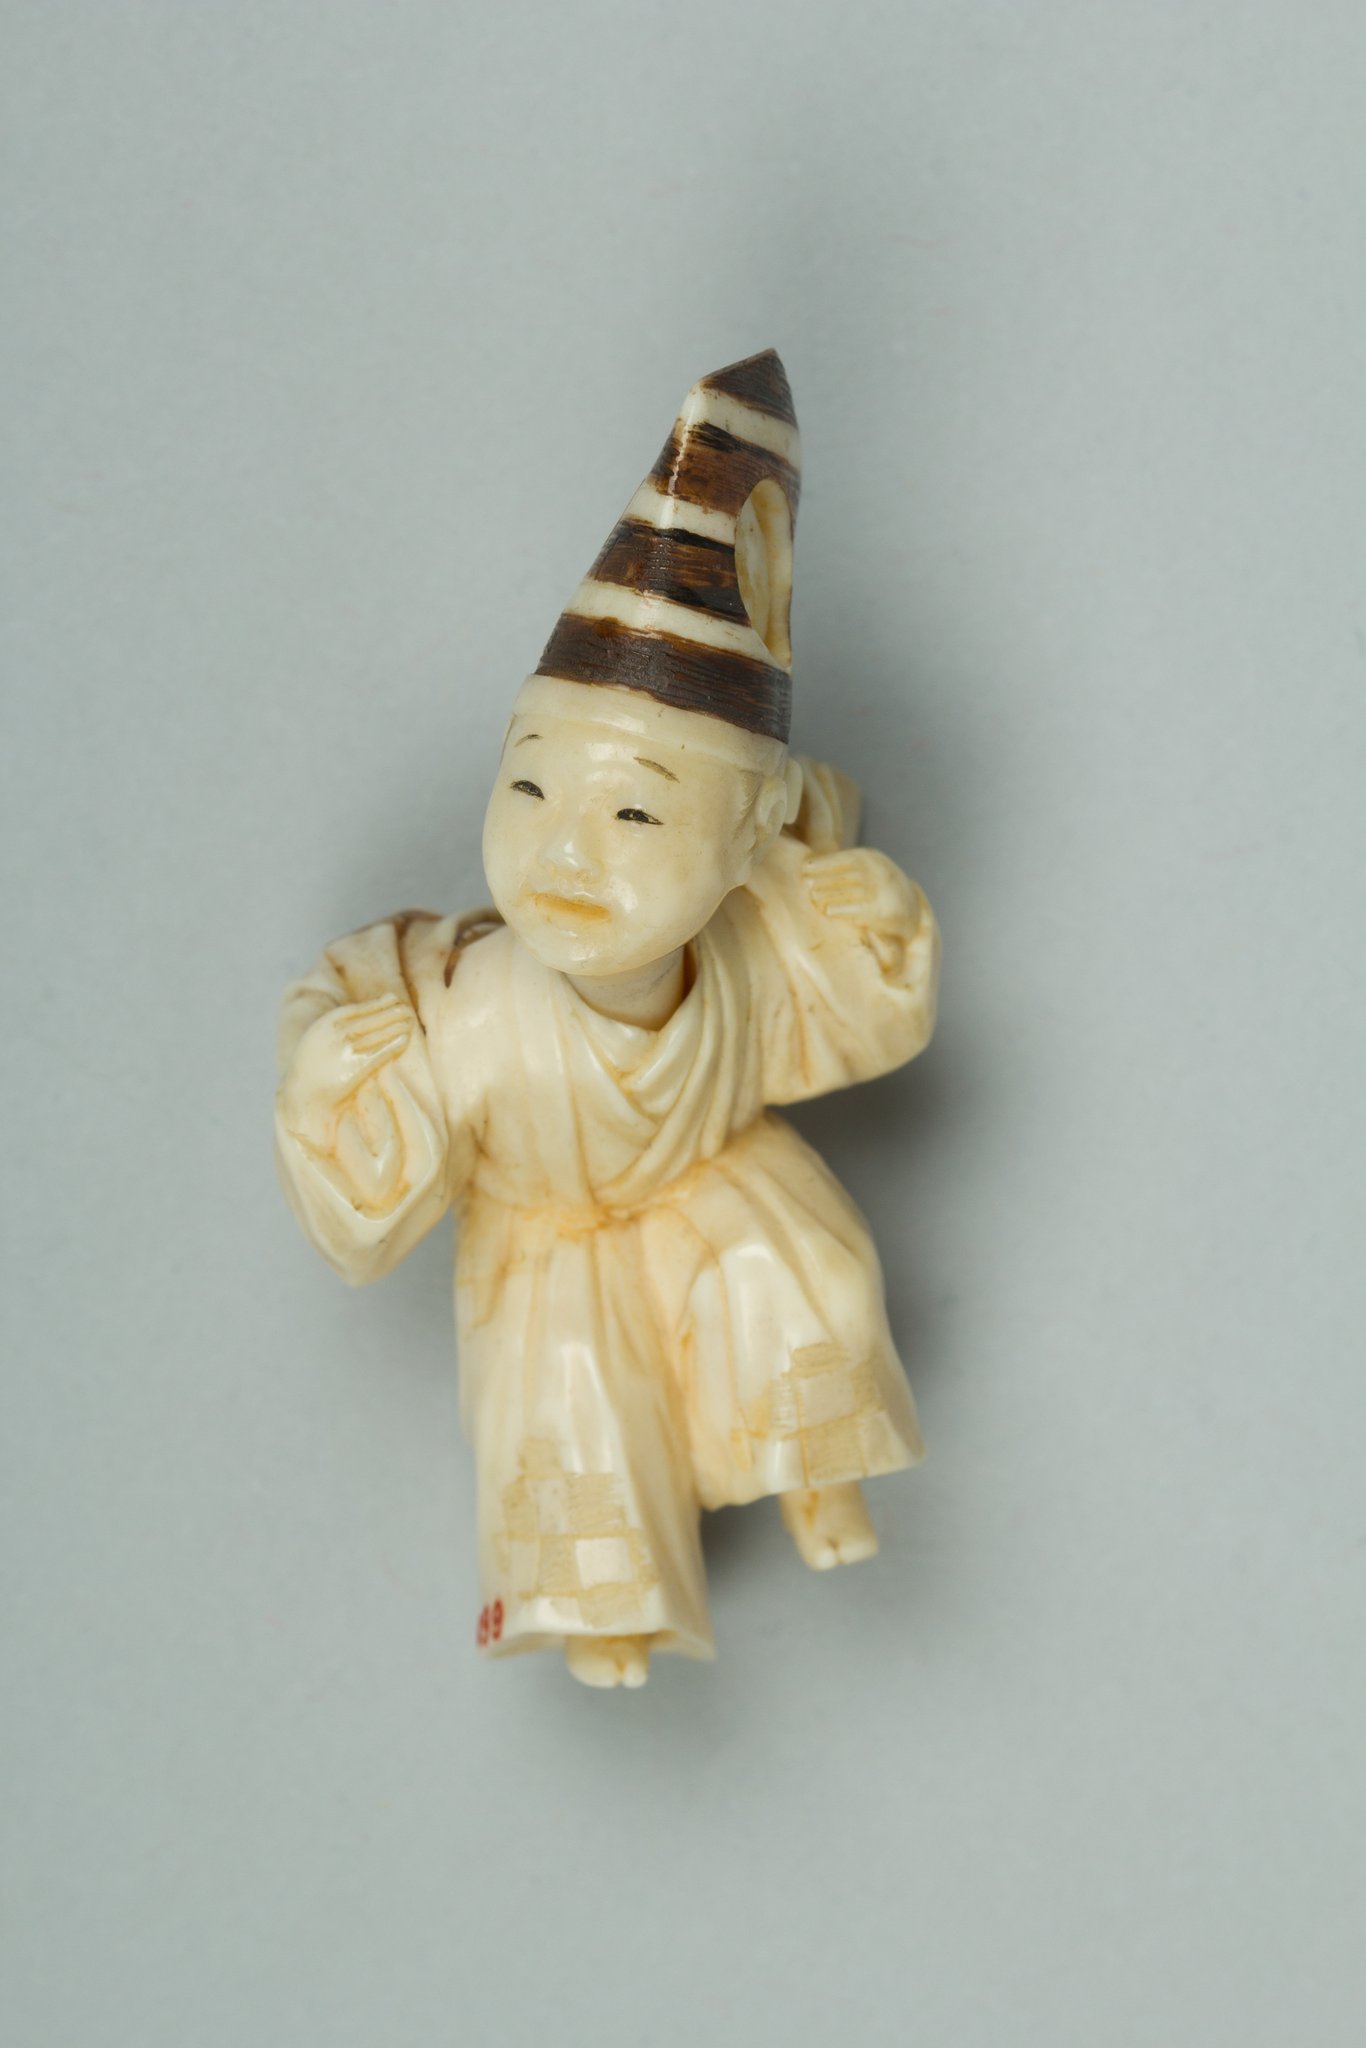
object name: netsuke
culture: japanese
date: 1801-1900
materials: coral, ivory, mother of pearl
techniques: inlay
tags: men